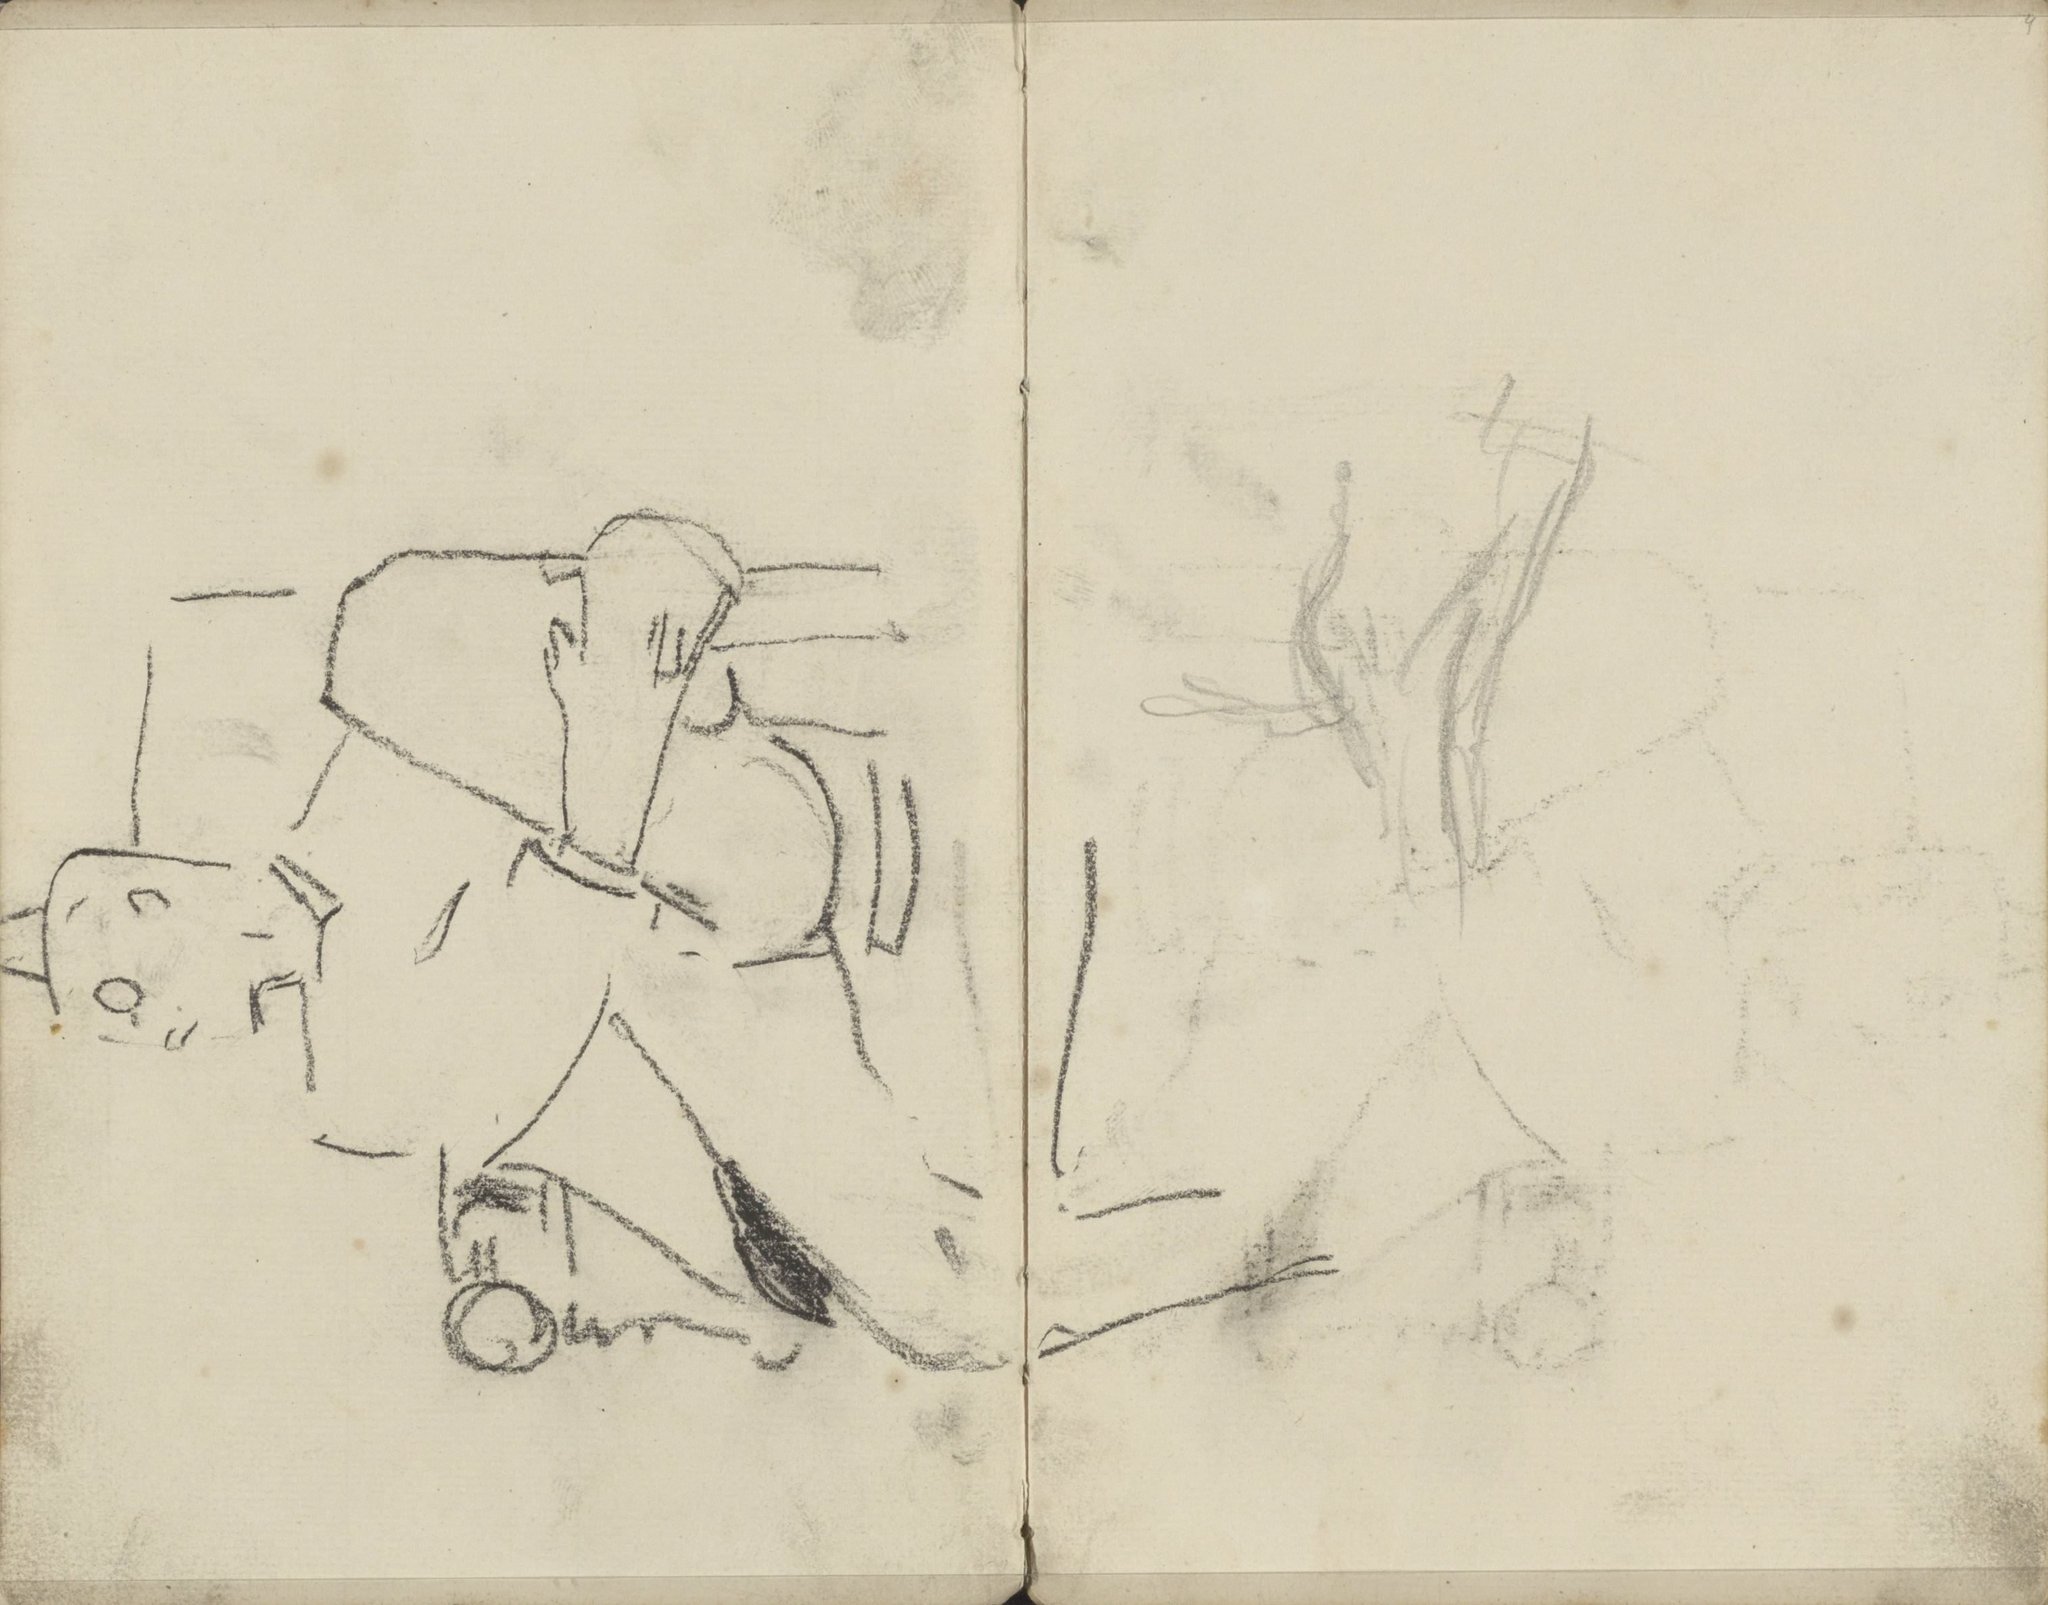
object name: sketchbook leaf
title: Zittende man met een opgetrokken been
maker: george hendrik breitner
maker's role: draughtsman, painter, print maker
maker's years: 1857-1923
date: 1886-1903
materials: chalk, paper, pencil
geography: amsterdam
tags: armchair, seat, sitting on an elevation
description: Pagina 3 en pagina 4 uit een schetsboek met 15 bladen.